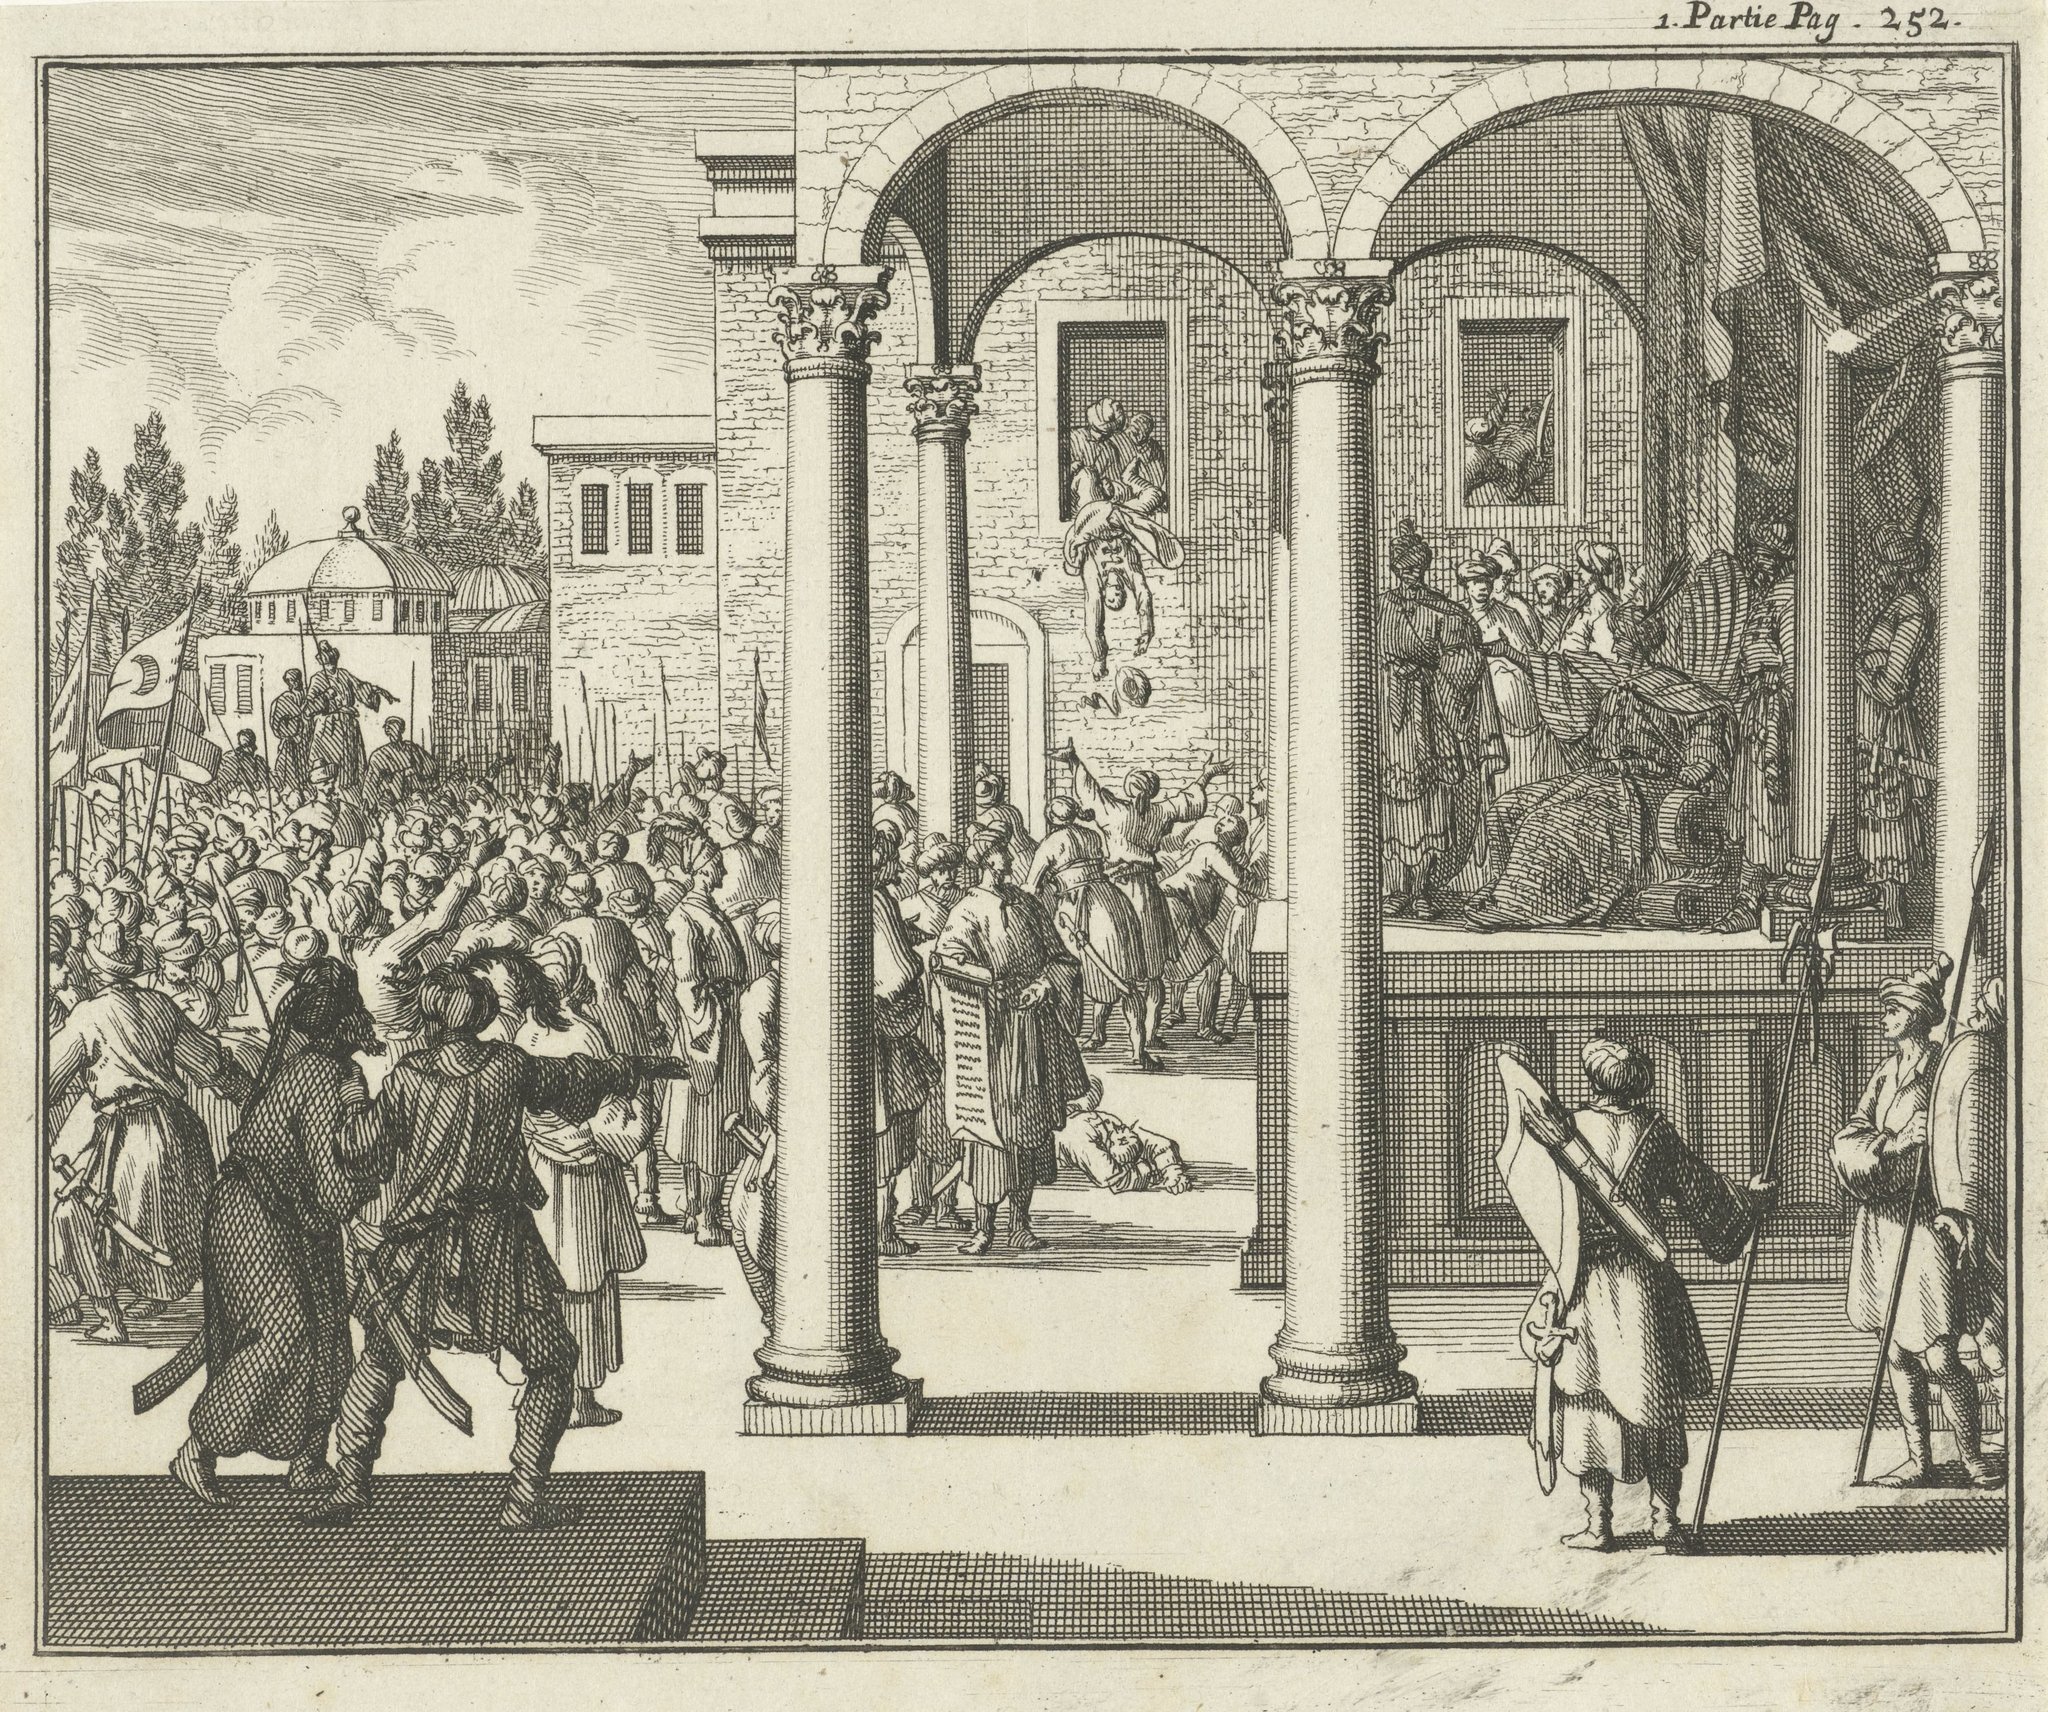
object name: book illustration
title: Man op troon onderhandelt met de aanvoerders van de oproerige Janitzaren te Constantinopel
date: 1689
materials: paper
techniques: etching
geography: amsterdam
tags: mutiny, rebellion ~ military discipline, ruler and his subjects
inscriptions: collector's mark: Lugt 2228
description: Illustratie uit: Thevenot, Jean de. Voyages Tant en Europe qu'en Asie et en Afrique, 4 delen. Parijs: Charles Angot, 1689, dl. I.